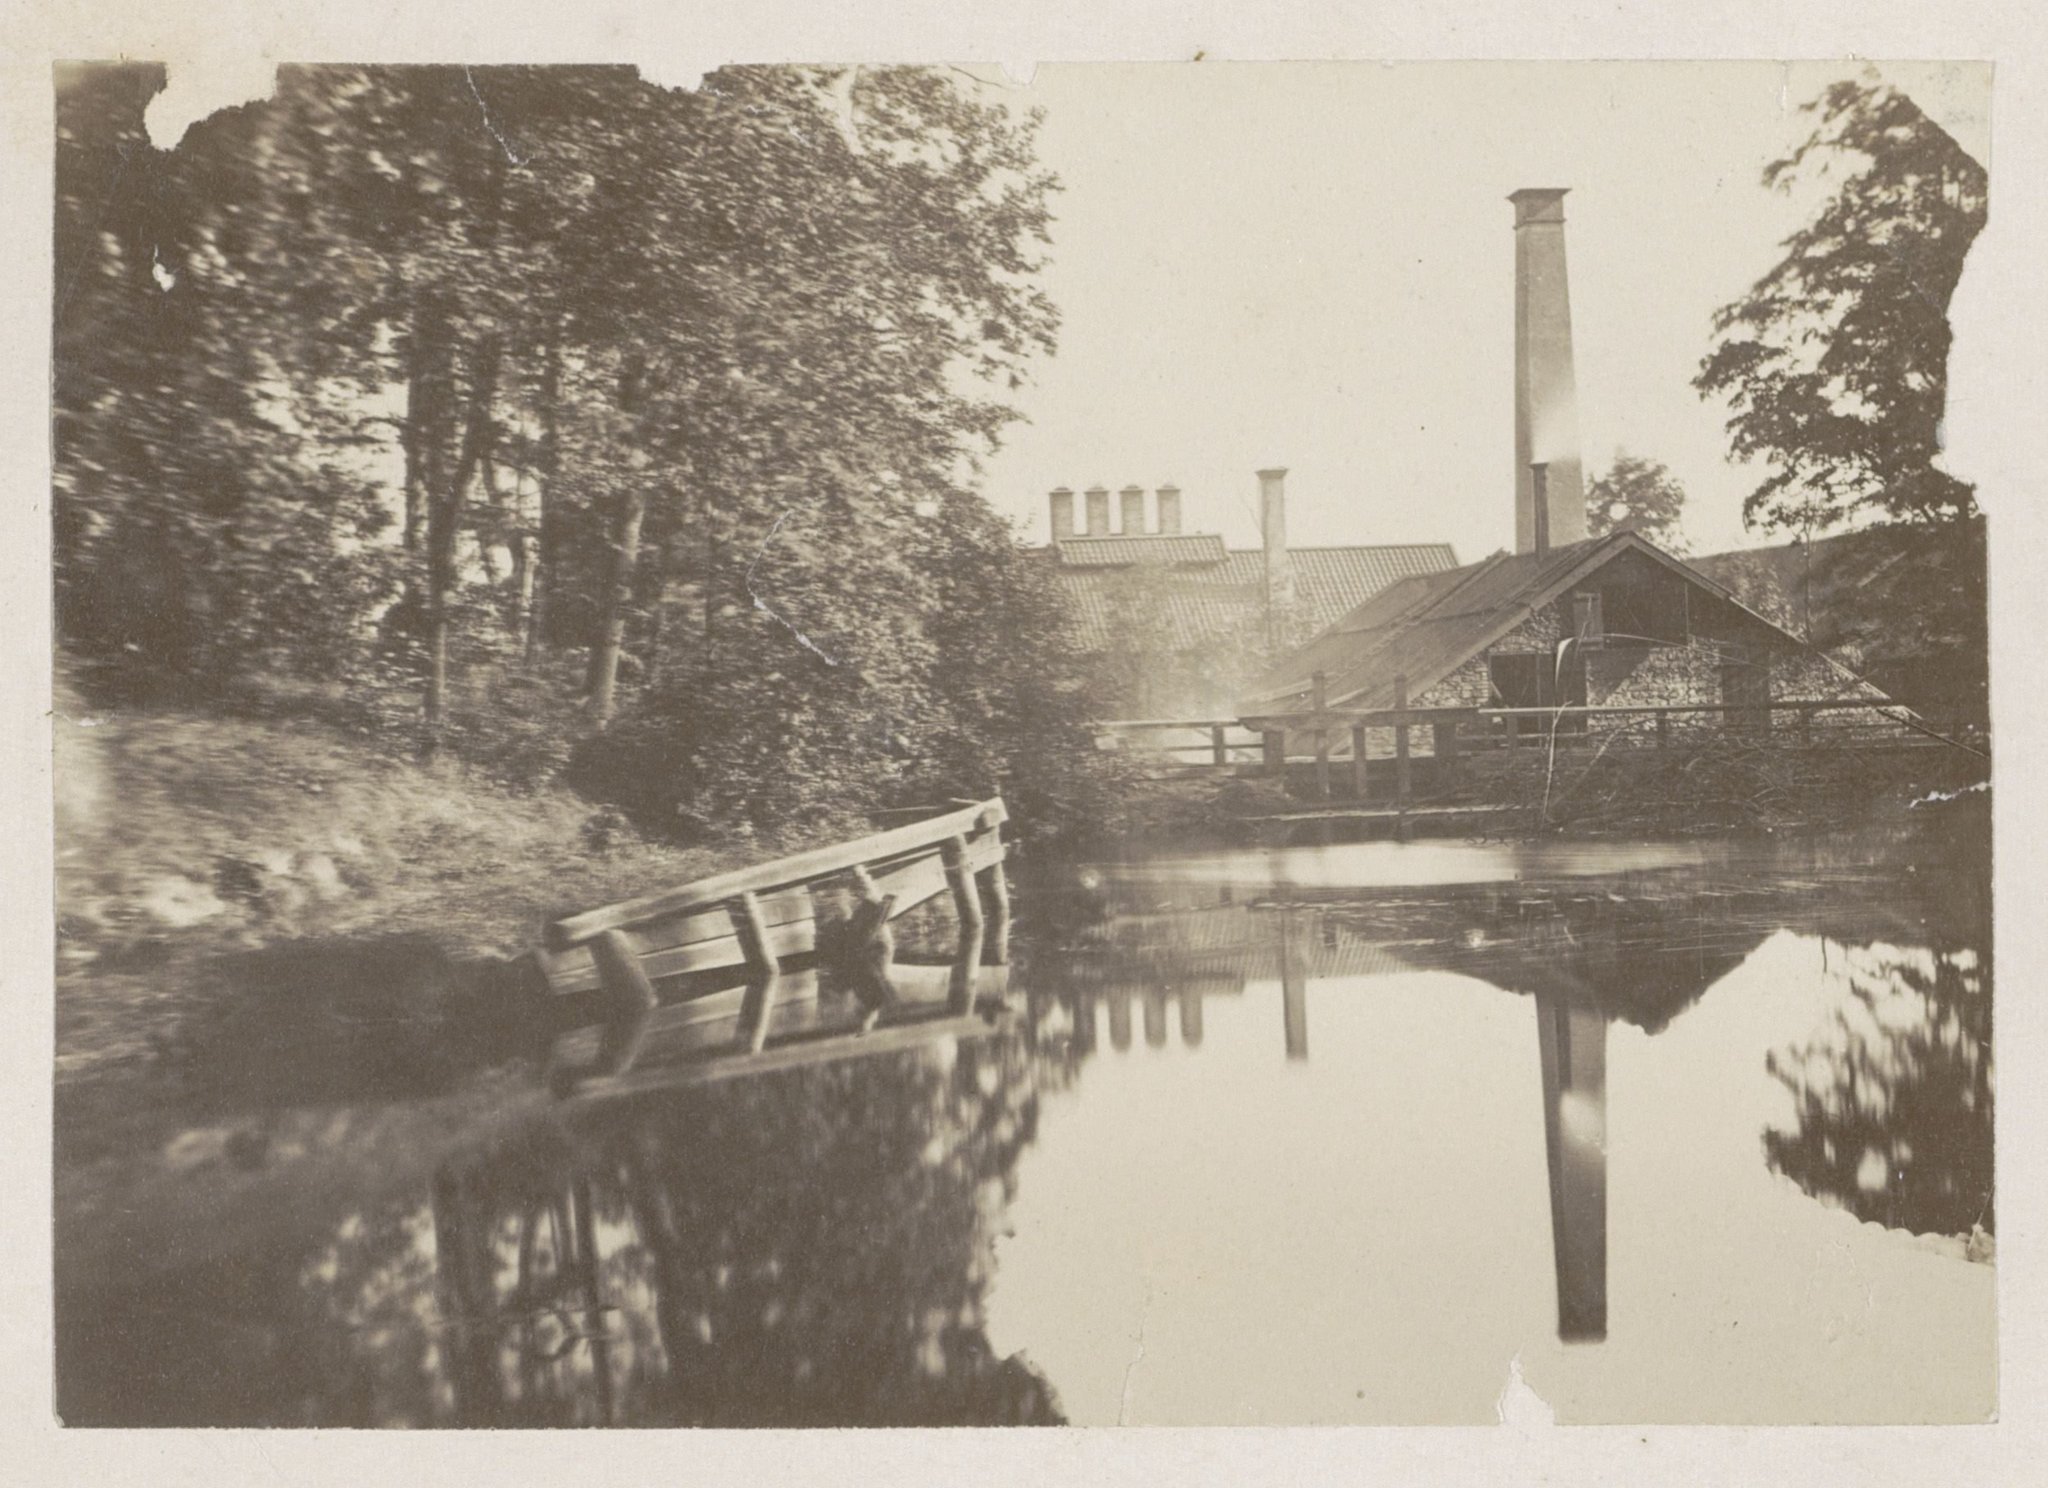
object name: photograph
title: Fabrieksgebouw met een schoorsteen aan een water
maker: Anonymous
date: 1878-1890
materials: photographic support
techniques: albumen print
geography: karlberg palace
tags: factory in landscape, workshop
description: Onderdeel van Reisalbum Europese steden, vermoedelijk Zweeds.